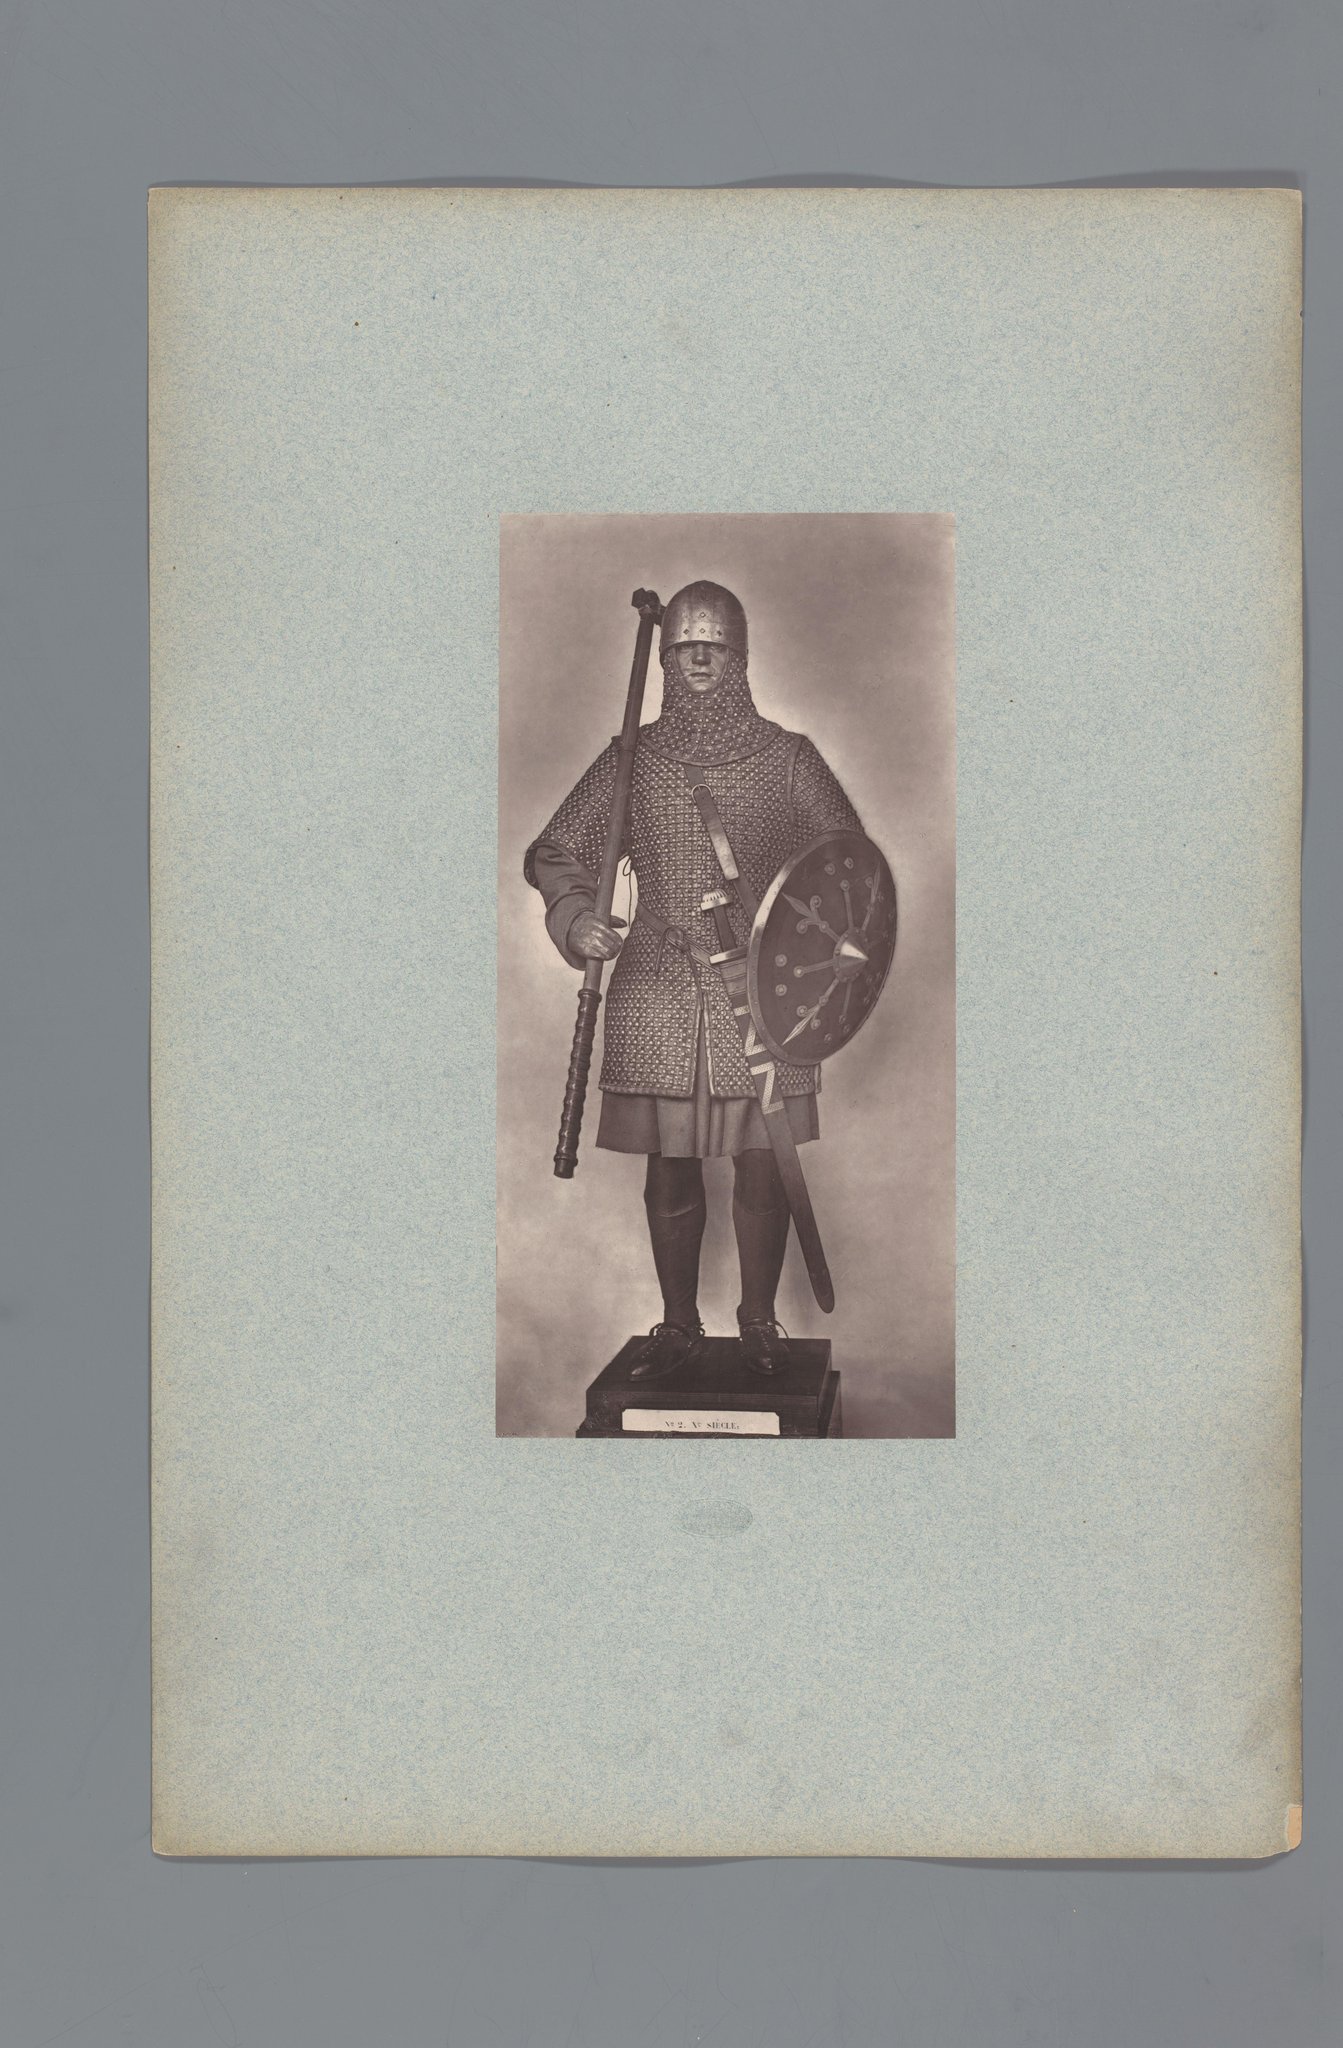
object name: photomechanical print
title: 10de-eeuws harnas voor een ruiter uit het leger van Hugo Capet, uit de collectie van het Musée d'Artillerie in Parijs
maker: Anonymous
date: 1877-1882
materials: paper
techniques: woodburytype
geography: paris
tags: protective weapons: shield, armour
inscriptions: check stamp: ‘PHOTOGLYPTIE/ LEMERCIER ET Cie/ PARIS’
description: Deze prent maakt deel uit van een omslag met 36 prenten, een titelblad en een lijst van afbeeldingen.